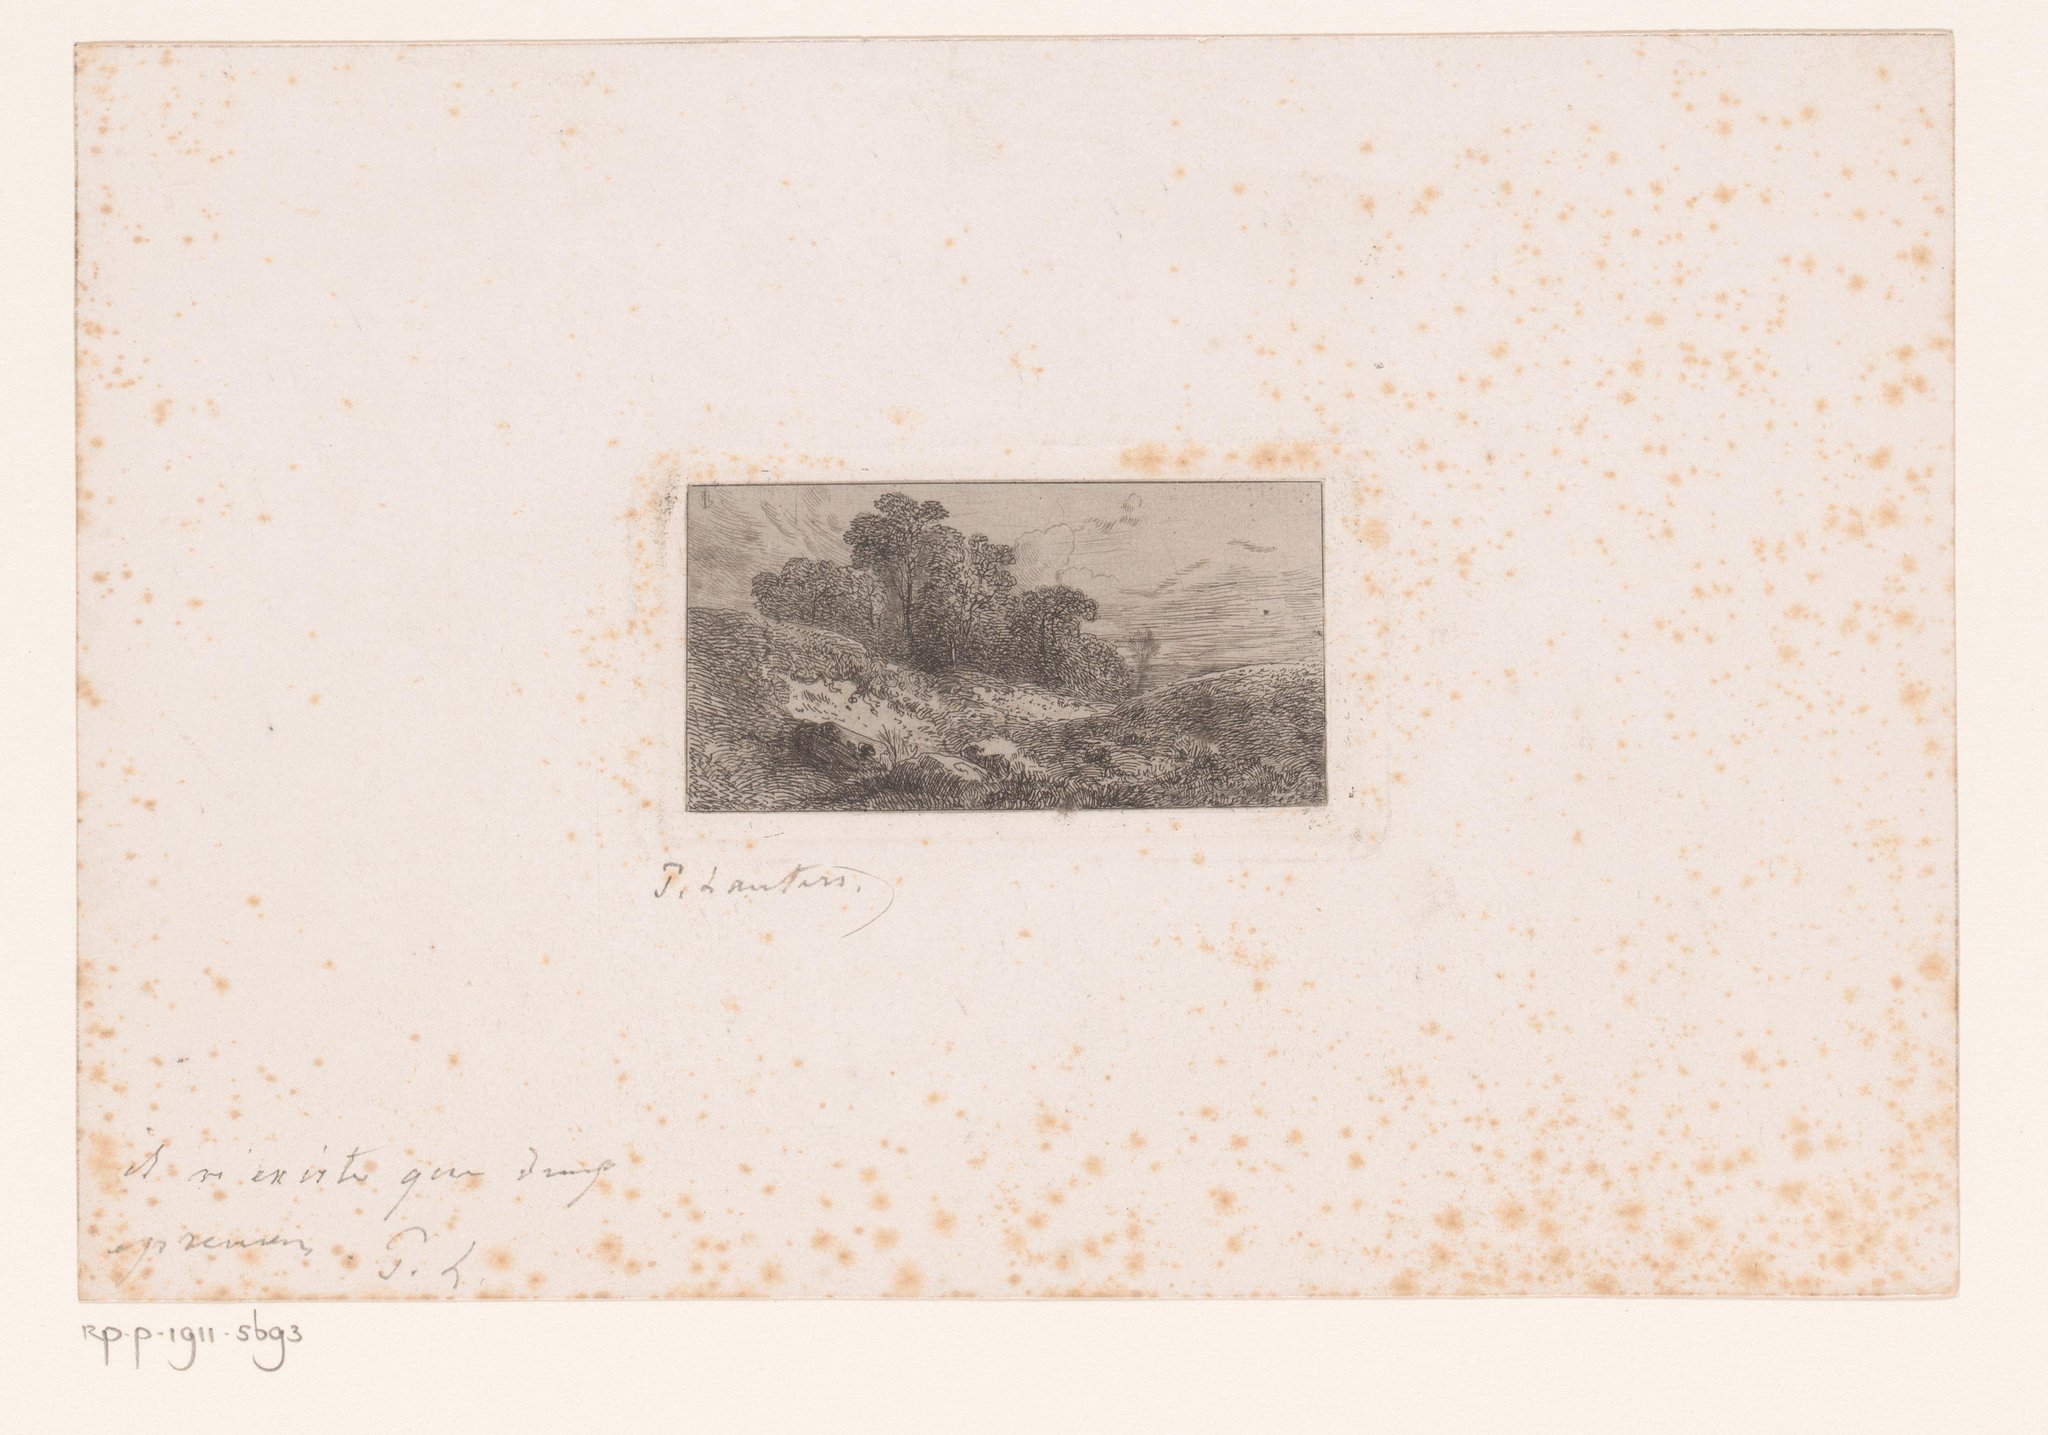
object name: print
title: Duinlandschap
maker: paulus lauters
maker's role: print maker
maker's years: 1806-1875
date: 1816-1875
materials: paper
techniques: etching, intaglio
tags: dune coast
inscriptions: annotation: ‘Il n'existe que trois (?) épreuves P.L.’, collector's mark: Lugt 2228